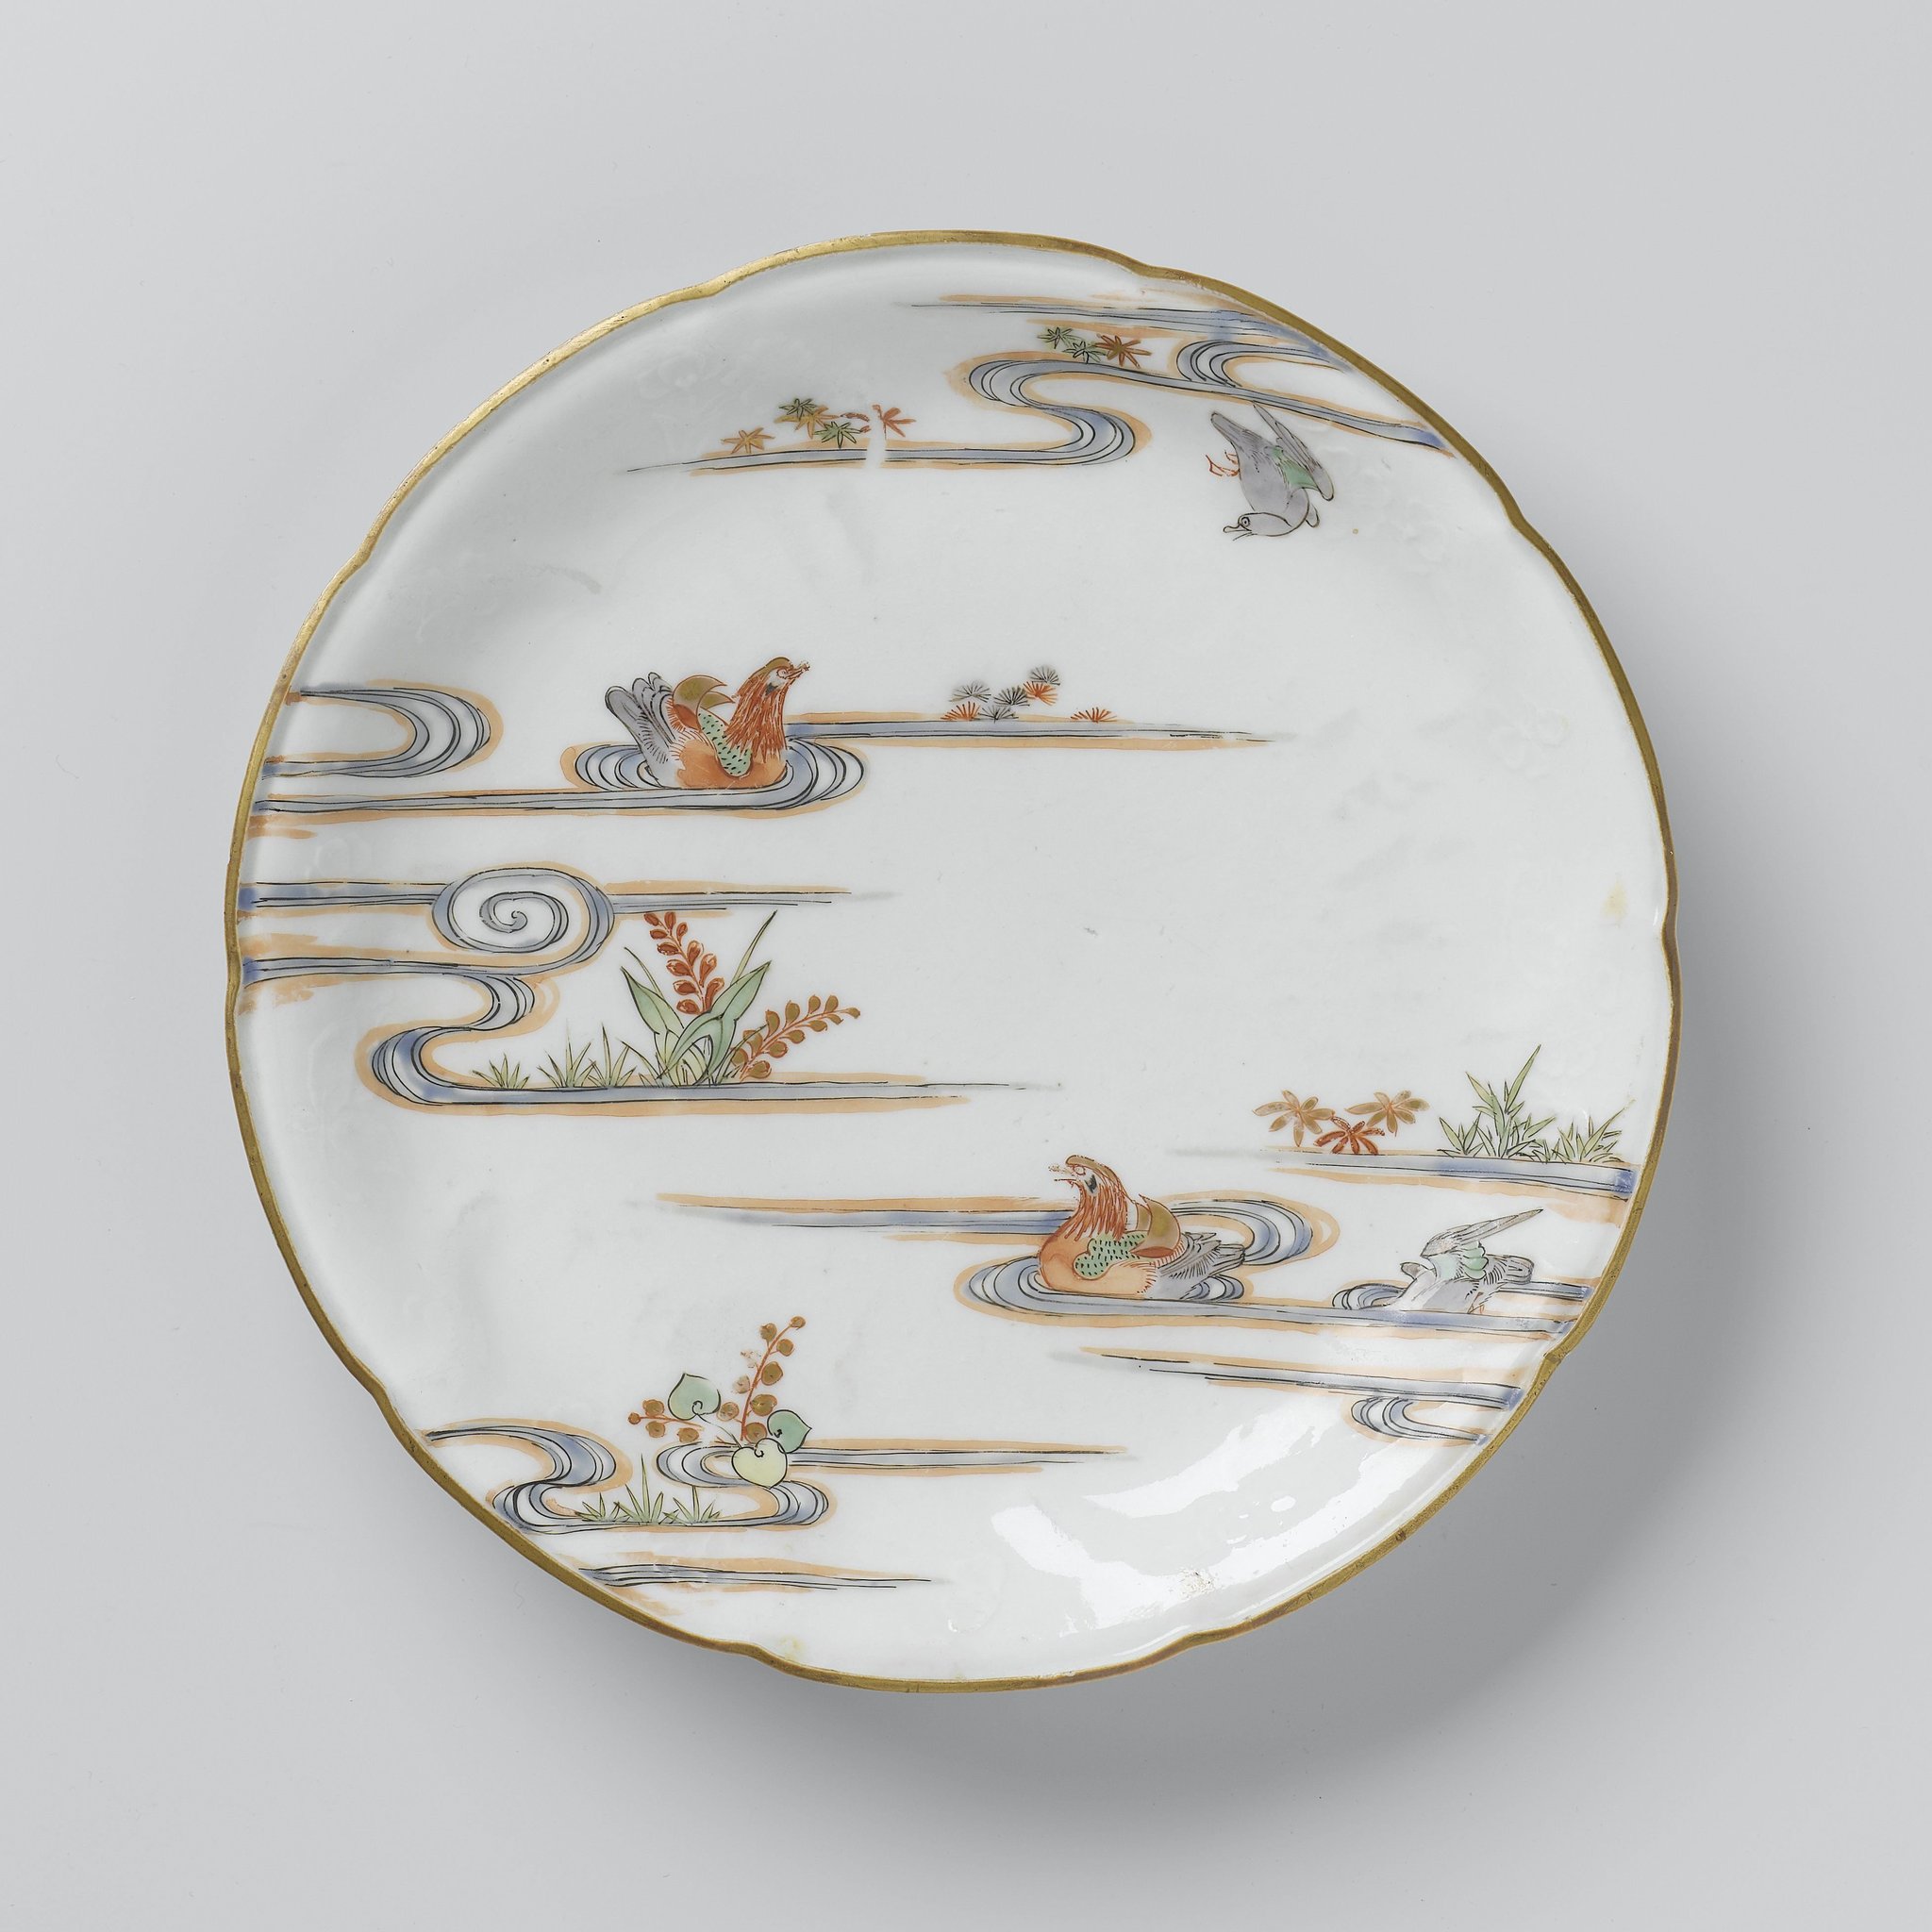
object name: dish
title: Saucer-dish with flower sprays in relief and two mandarin ducks in a pond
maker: Anonymous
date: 1675-1724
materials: glaze, gold, paint, porcelain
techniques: firing, gilding, relief, turning, vitrification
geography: japan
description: Schaal van porselein met een geschulpte rand, beschilderd op het glazuur in blauw, rood, groen, geel, aubergine, zwart en goud. Op de voorzijde op de wand bloemtakken in reliëf; daaroverheen in emailkleuren twee mandarijneenden in een vijver met planten en een vliegende vogel. De buitenzijde met bloeiende waterplanten. Vijf proenen op de onderzijde. Kakiemon-stijl.